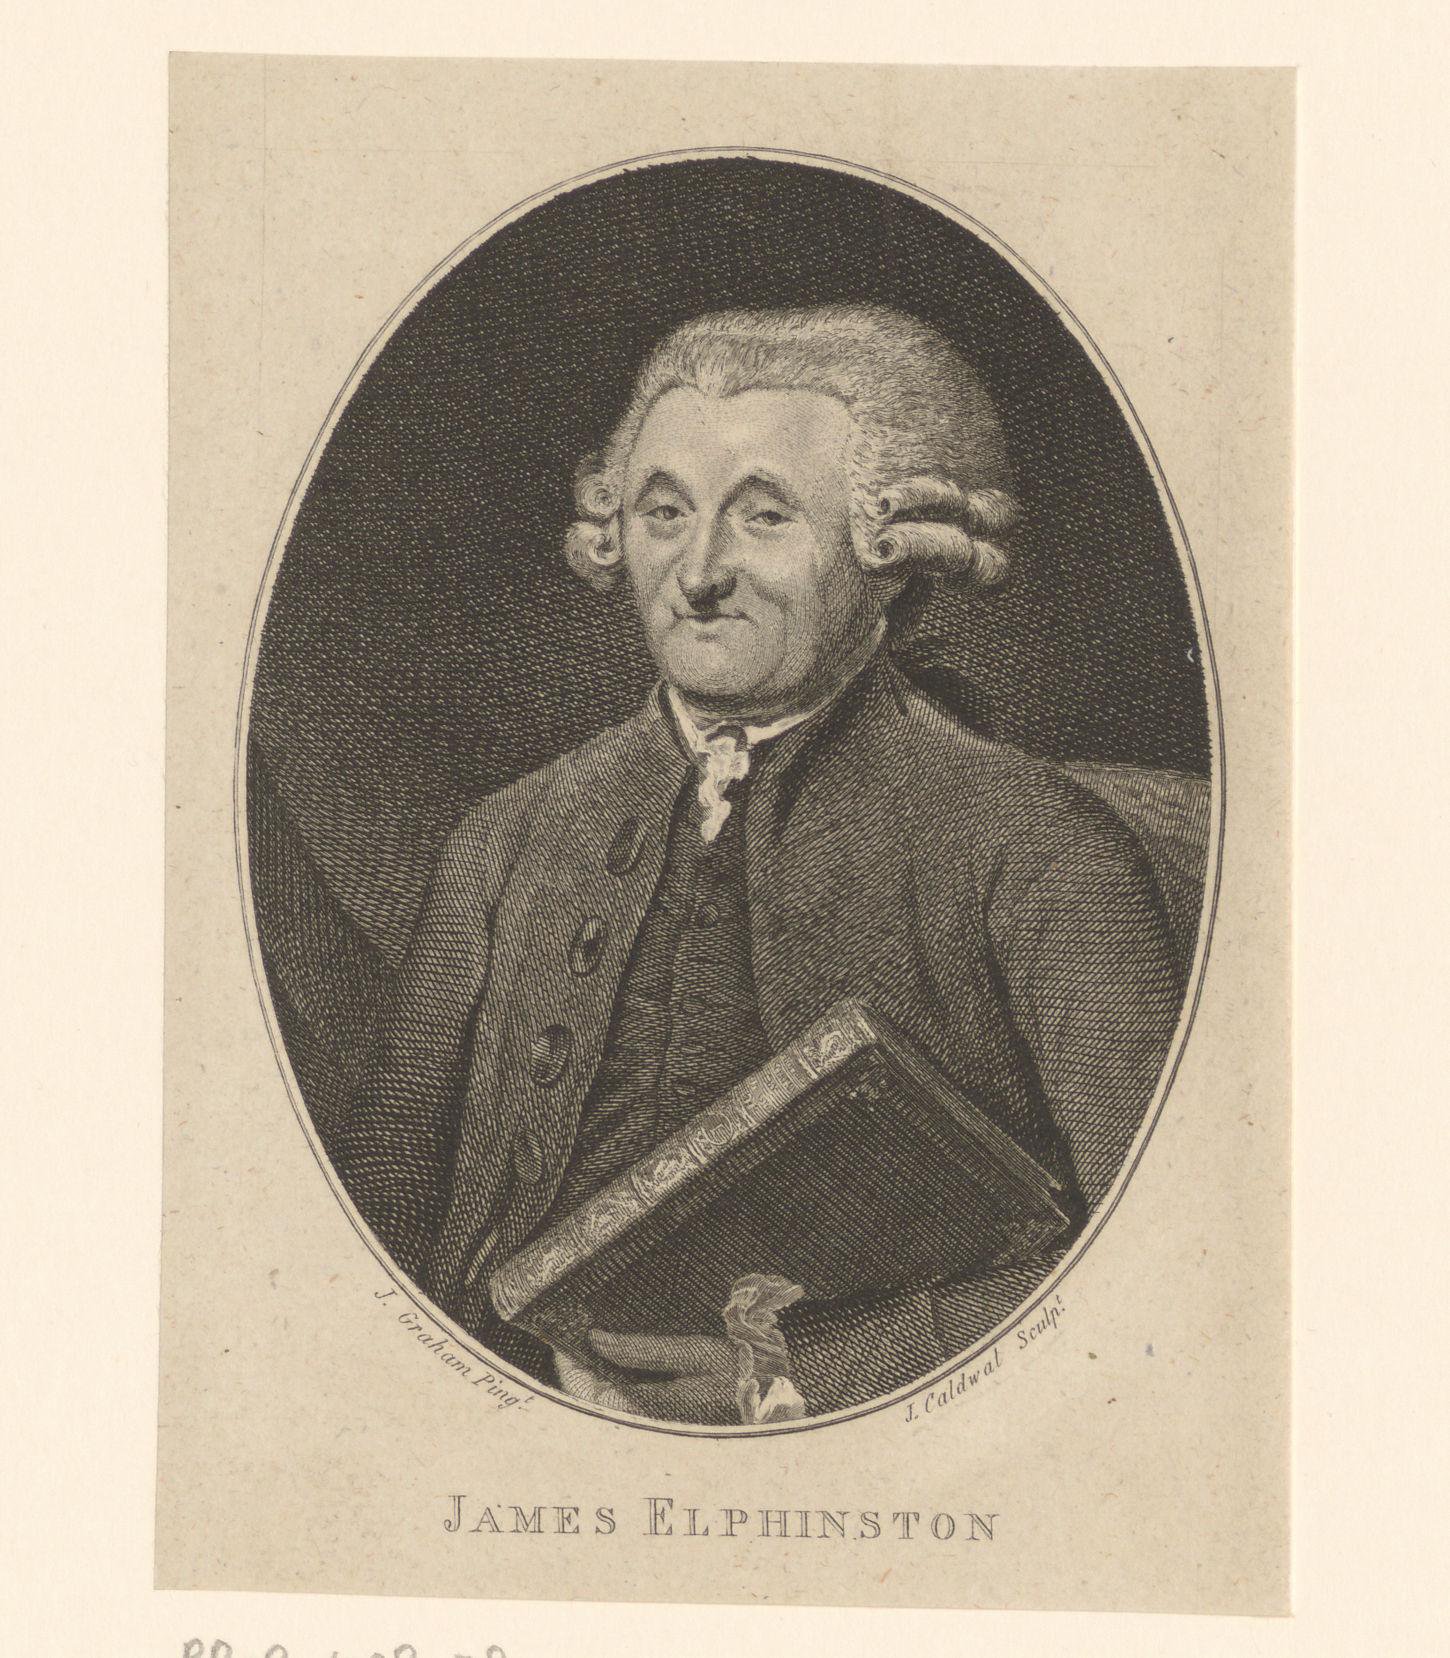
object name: print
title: Portret van James Elphinston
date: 1780-1800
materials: paper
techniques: etching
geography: england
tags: linguistics (+ portrait of scholar, scientist), historical persons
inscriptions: collector's mark: Lugt 2228